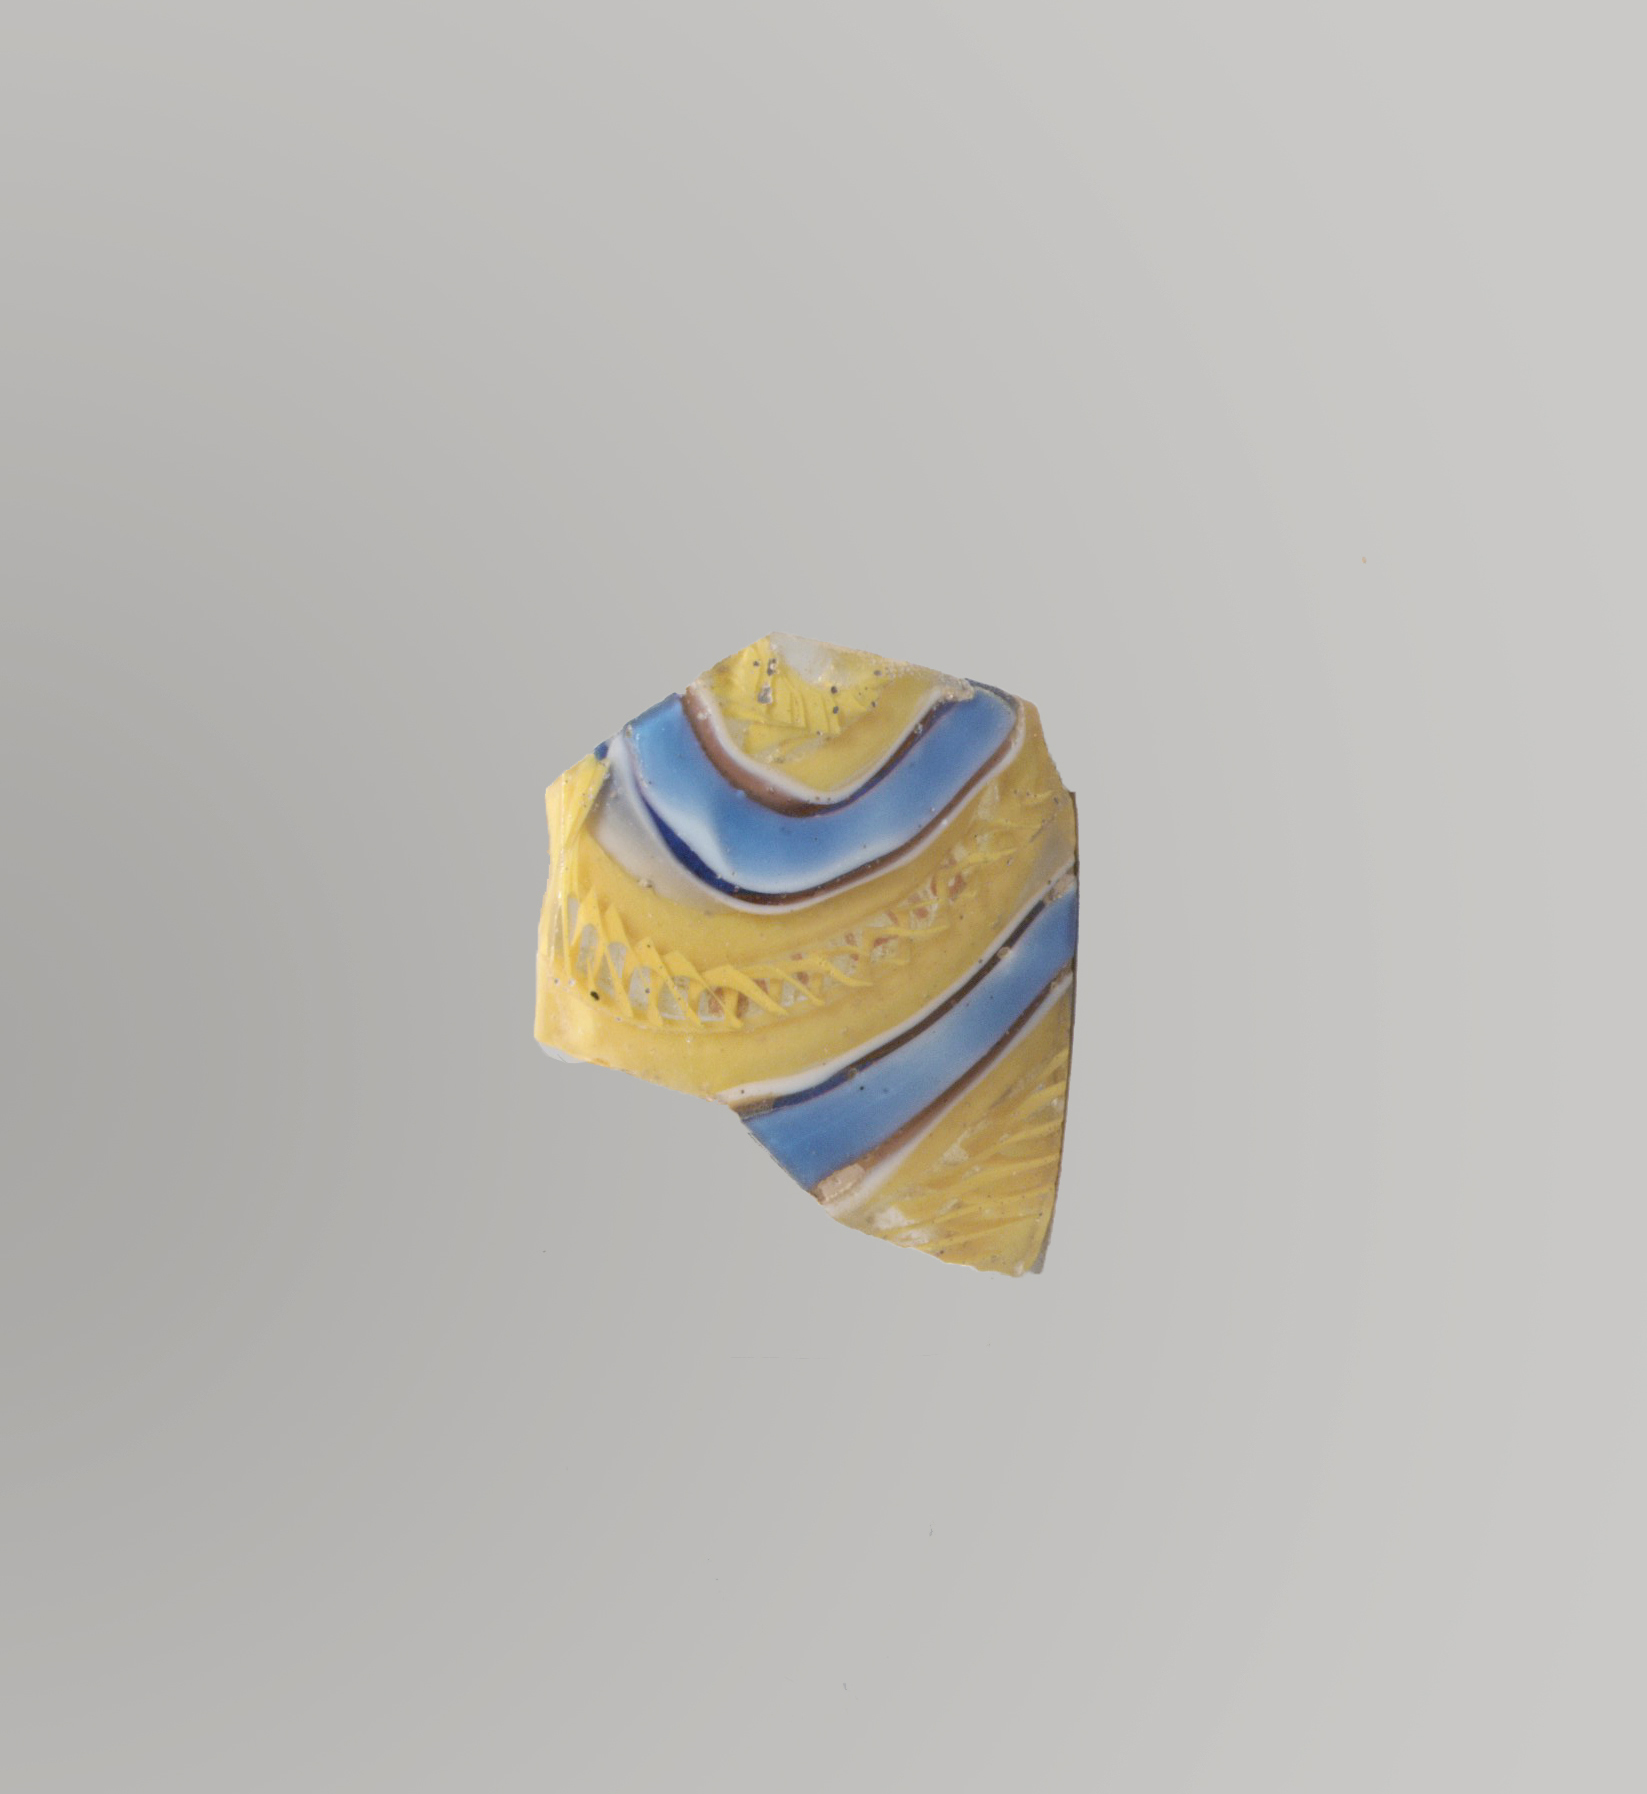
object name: fragment, mosaic bowl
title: Glass mosaic bowl fragment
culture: roman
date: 34 BCE-33 CE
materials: glass